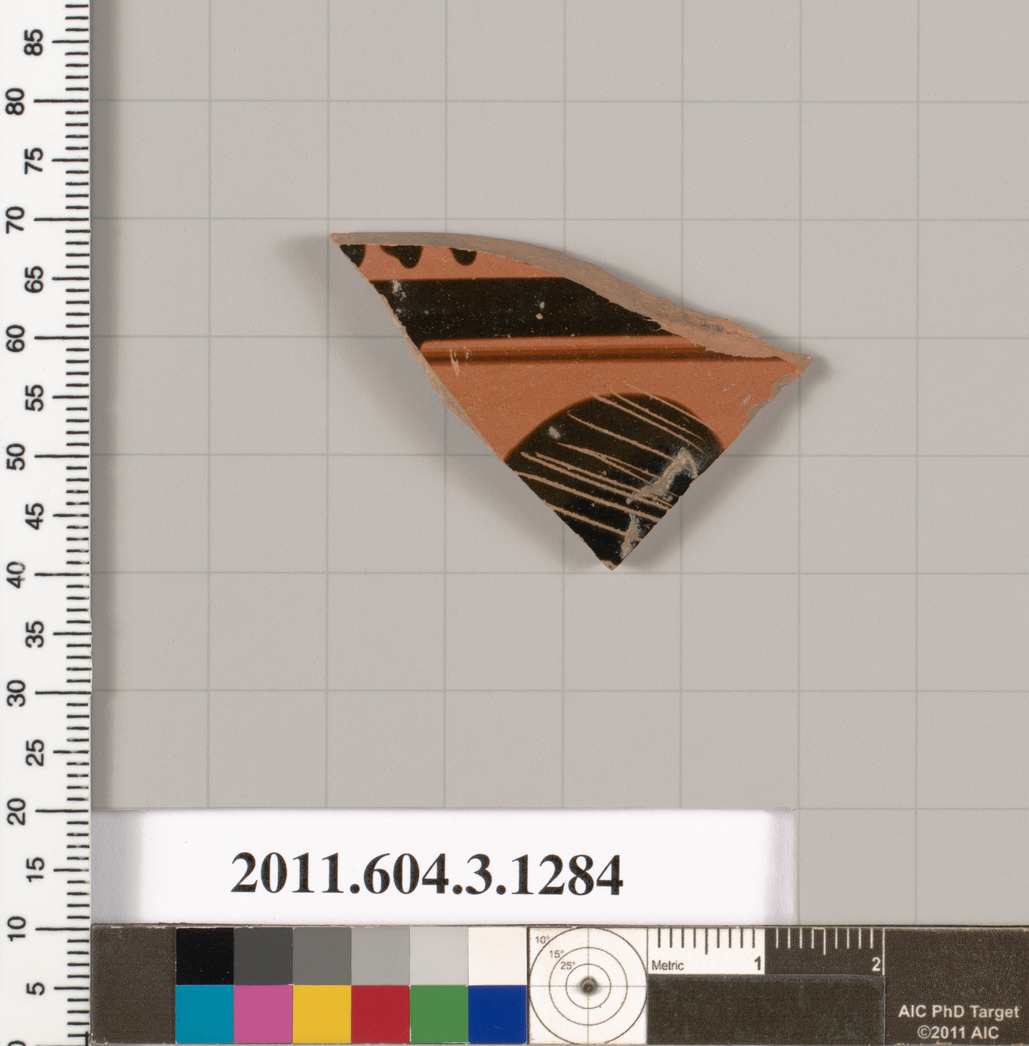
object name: skyphos fragment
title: Terracotta rim fragment of a skyphos (deep drinking cup)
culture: greek, attic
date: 500 BCE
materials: terracotta